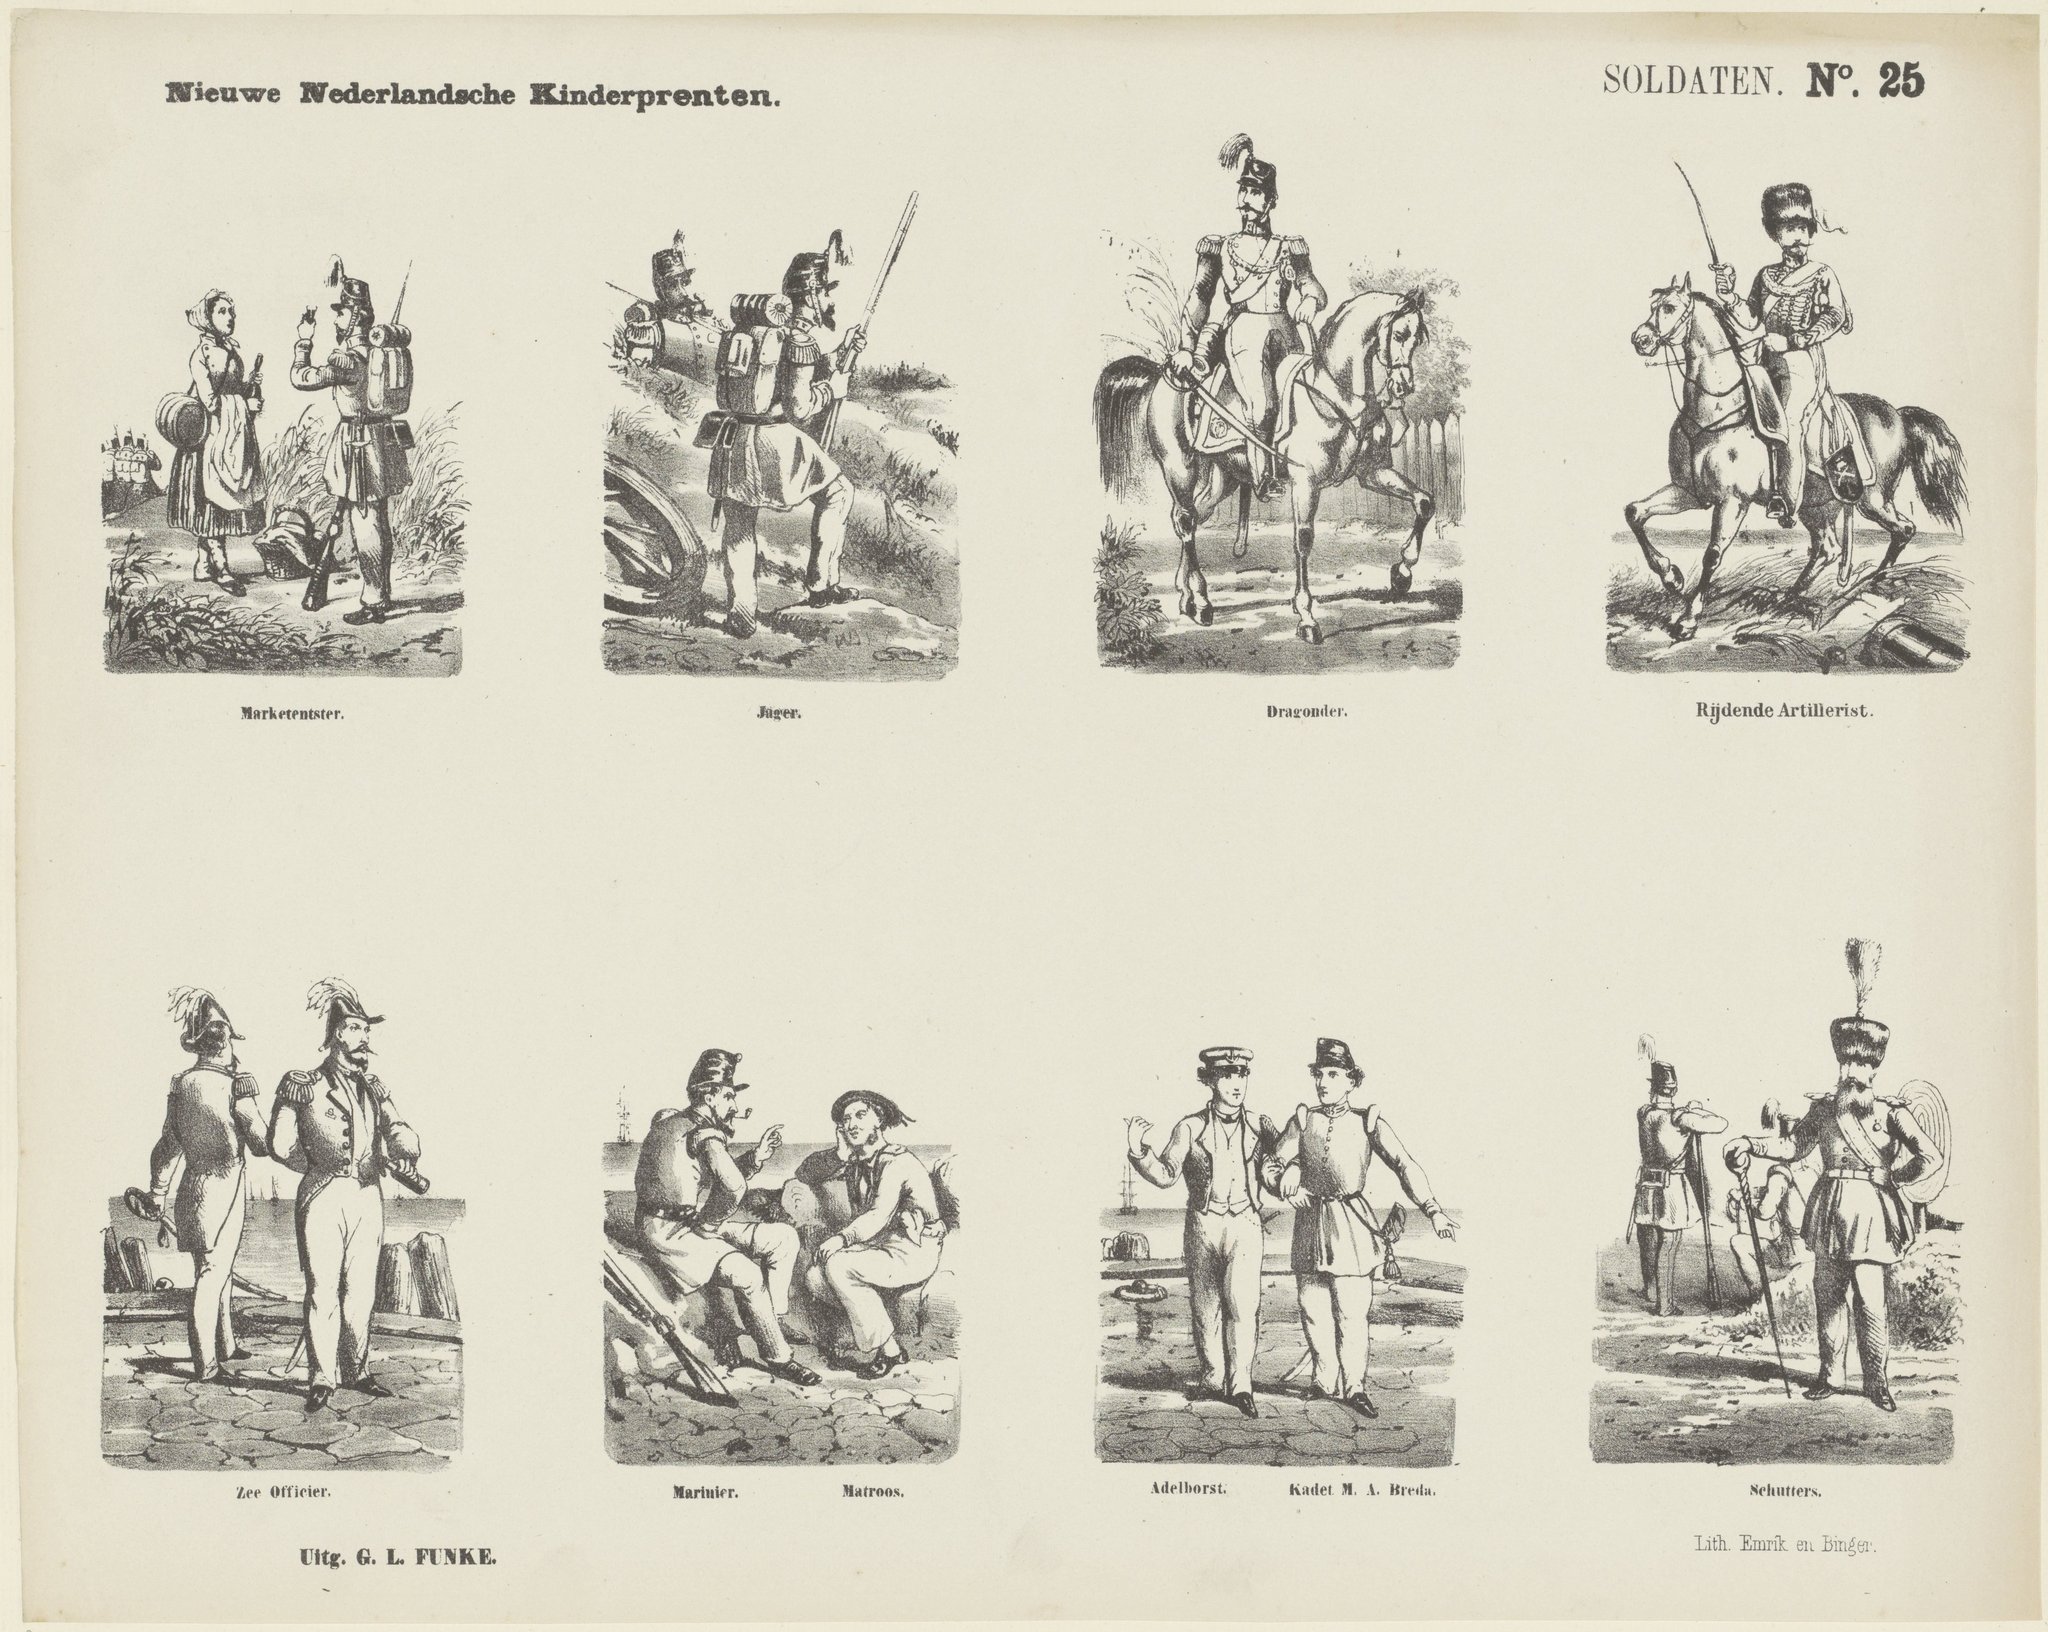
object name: print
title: Soldaten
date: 1865-1875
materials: paper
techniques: letterpress printing, lithograph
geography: amsterdam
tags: warfare; military affairs (+ cavalry, horsemen), sailor, the soldier; the soldier's life, (military) uniforms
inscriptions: collector's mark: Lugt 2760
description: Blad met 8 voorstellingen van militairen, onder anderen een dragonder, een officier en een matroos. Onder elke afbeelding een onderschrift. Genummerd rechtsboven: No. 25.